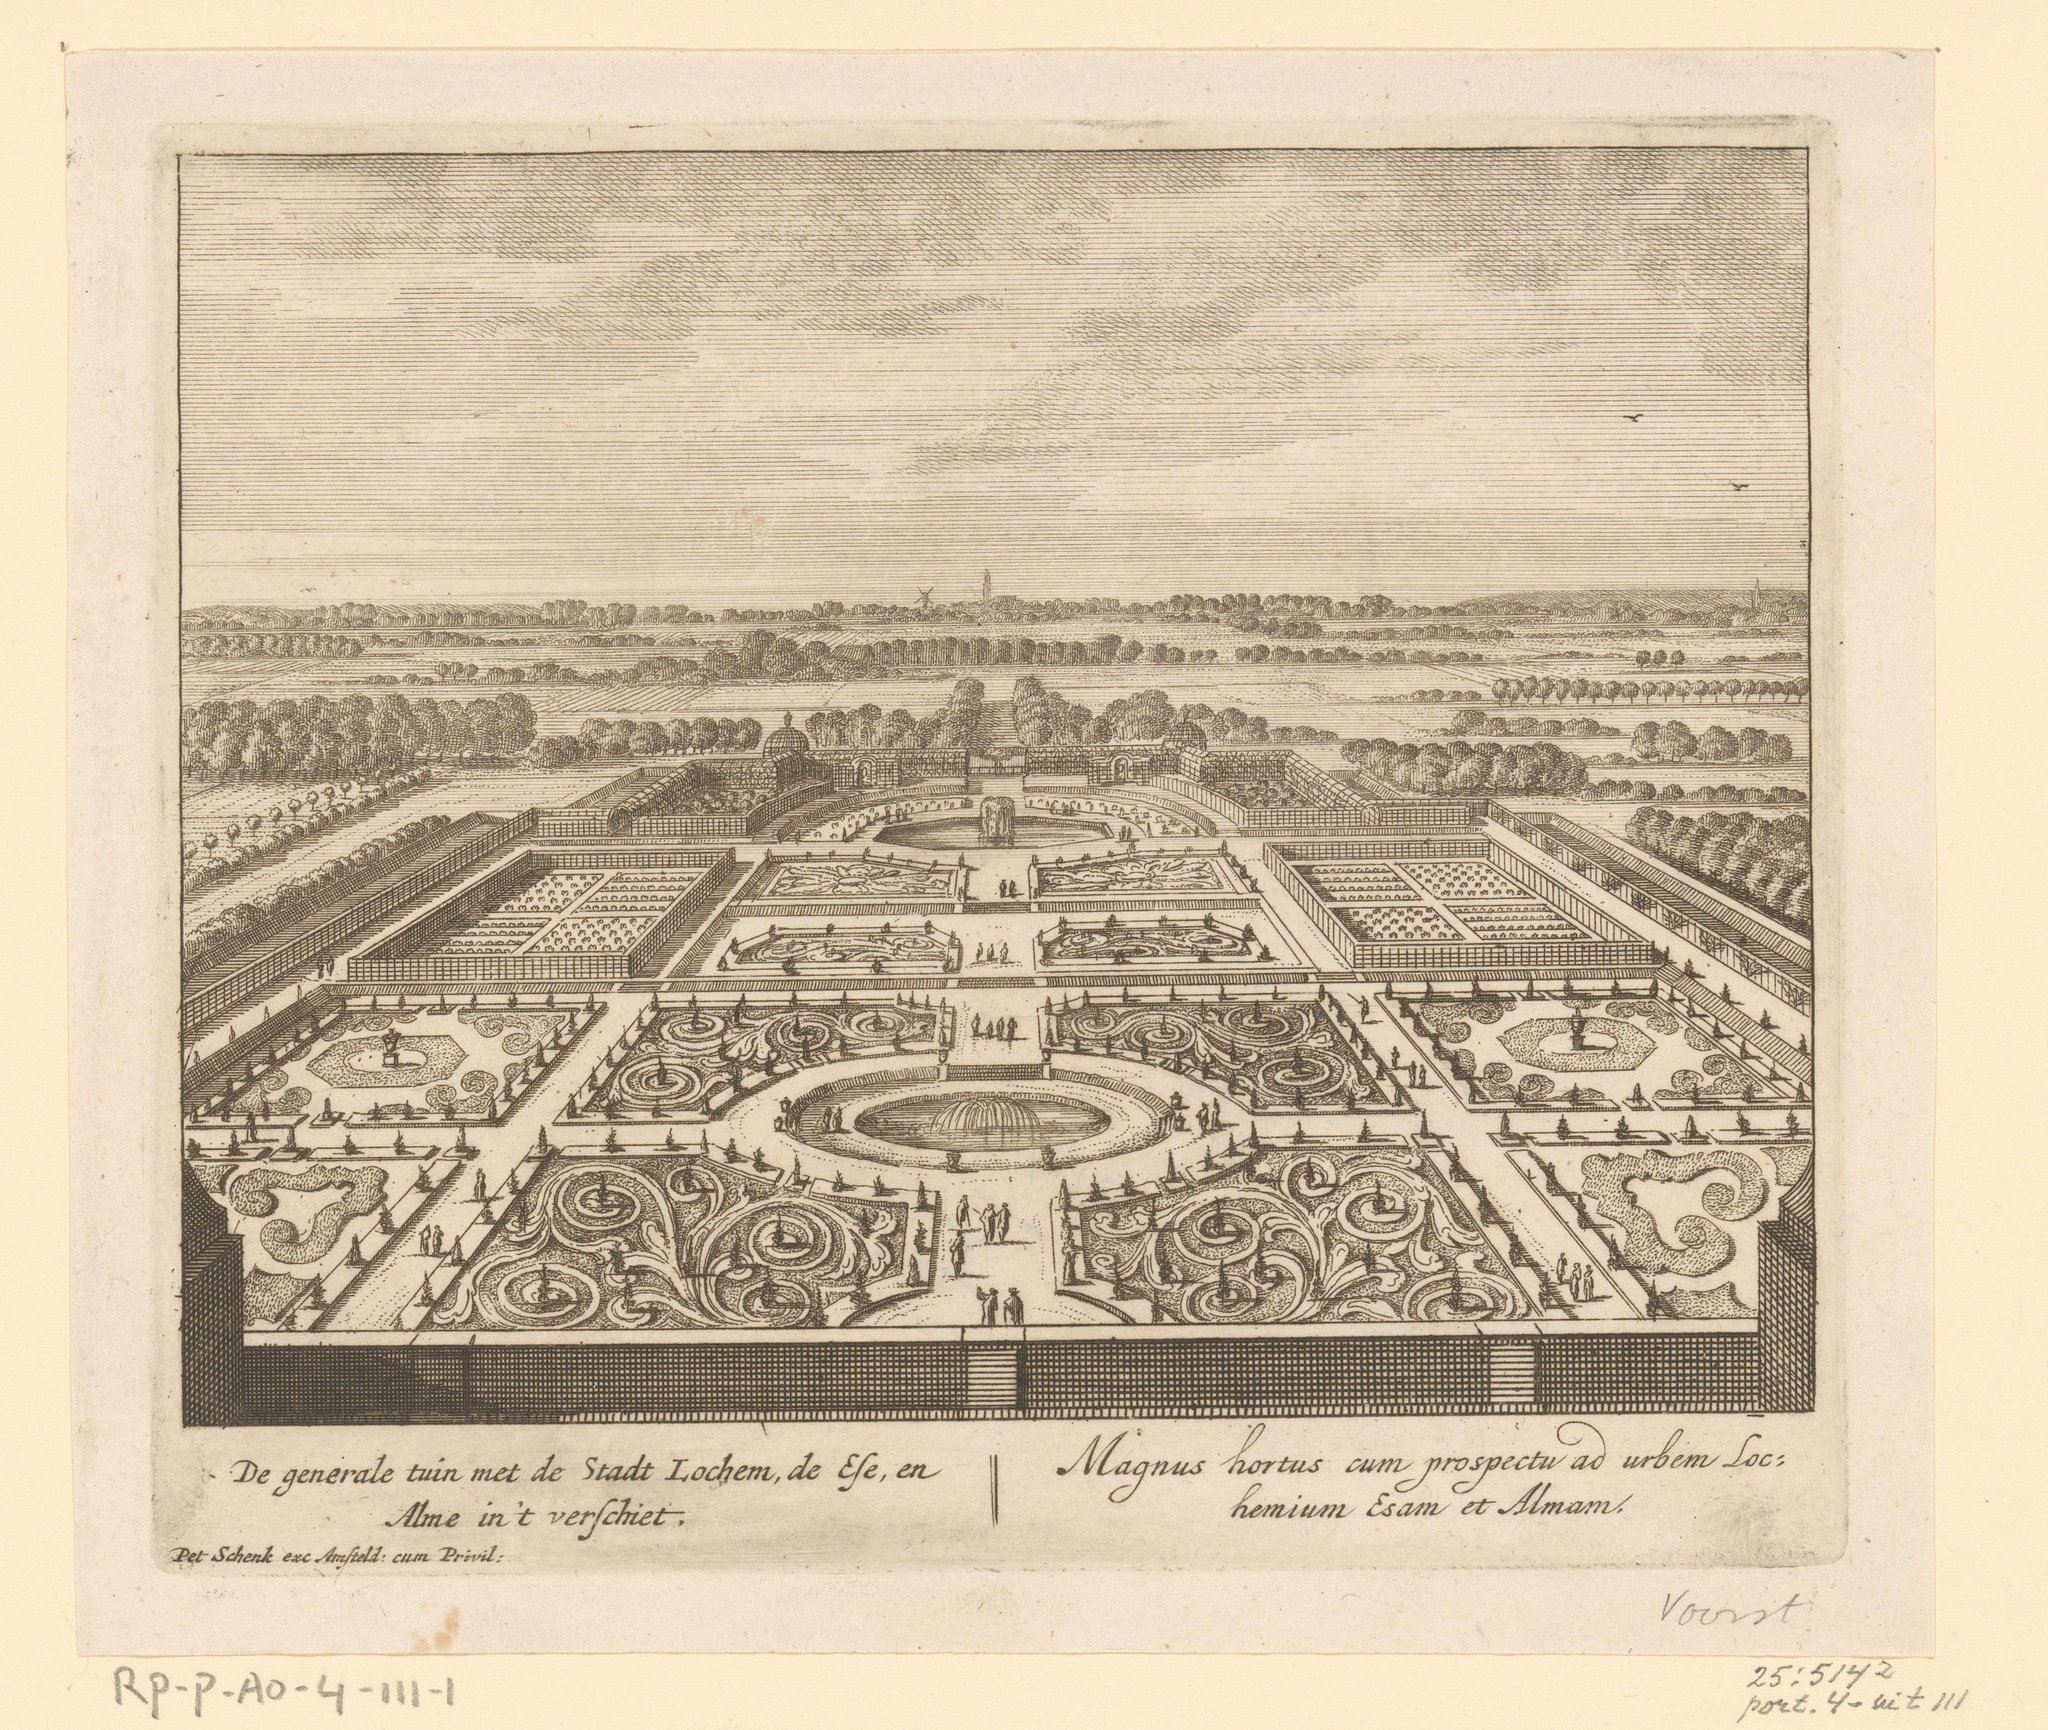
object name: print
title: De generale tuin met de stadt Lochem, de Ese, en Alme in 't verschiet / Magnus hortus cum prospectu ad urbem Lochemium Esam et Almam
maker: pieter schenk (i)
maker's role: print maker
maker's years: 1660-1711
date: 1700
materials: paper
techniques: engraving, etching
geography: amsterdam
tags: palace, french or architectonic garden; formal garden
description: Prent is uitgeven door Pieter Schenk (I) als onderdeel van de zestiendelige prentserie 'Praetorium Dieranum', ca. 1700. Later is de prent ook gebruikt in: Schenk, Pieter (I). Paradisus Oculorum: sive conspectus degantissimi centum (...). Jacobus Romanus, ca. 1700.